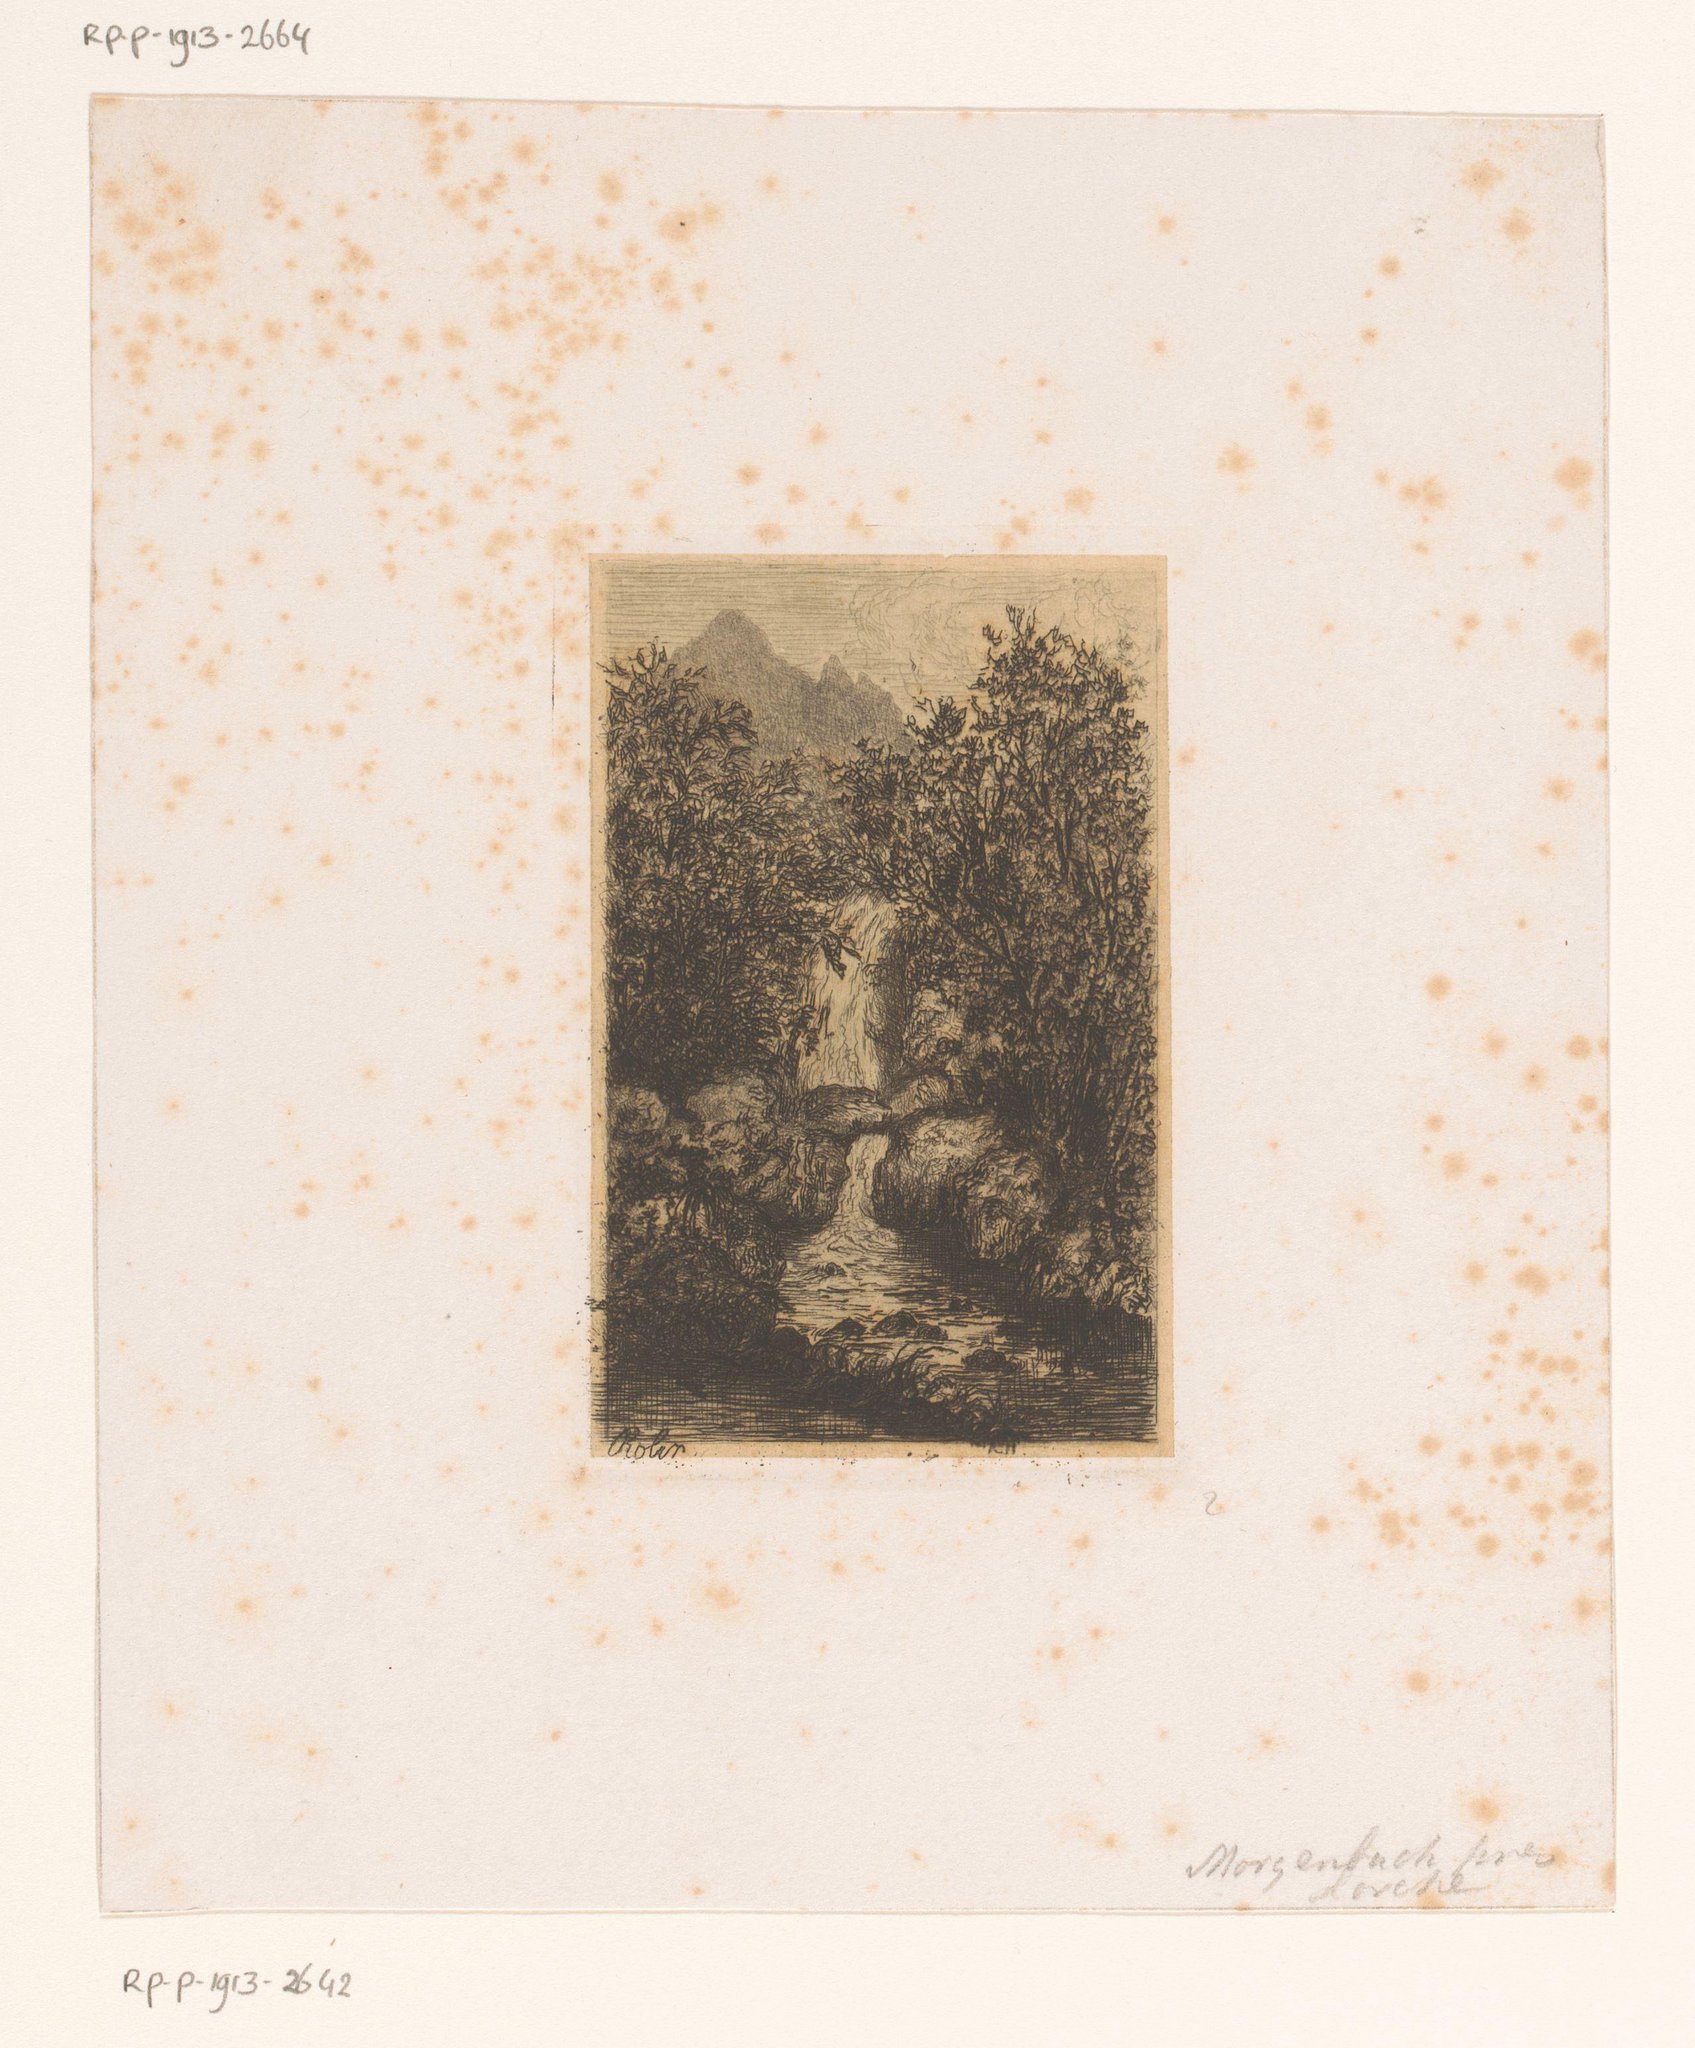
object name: print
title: Waterval bij Morgenbach nabij Lorch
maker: emilie rolin-jacquemijns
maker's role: print maker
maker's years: 1842-1906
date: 1852-1906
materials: paper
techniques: etching, intaglio, retroussage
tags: waterfall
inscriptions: collector's mark: Lugt 2228